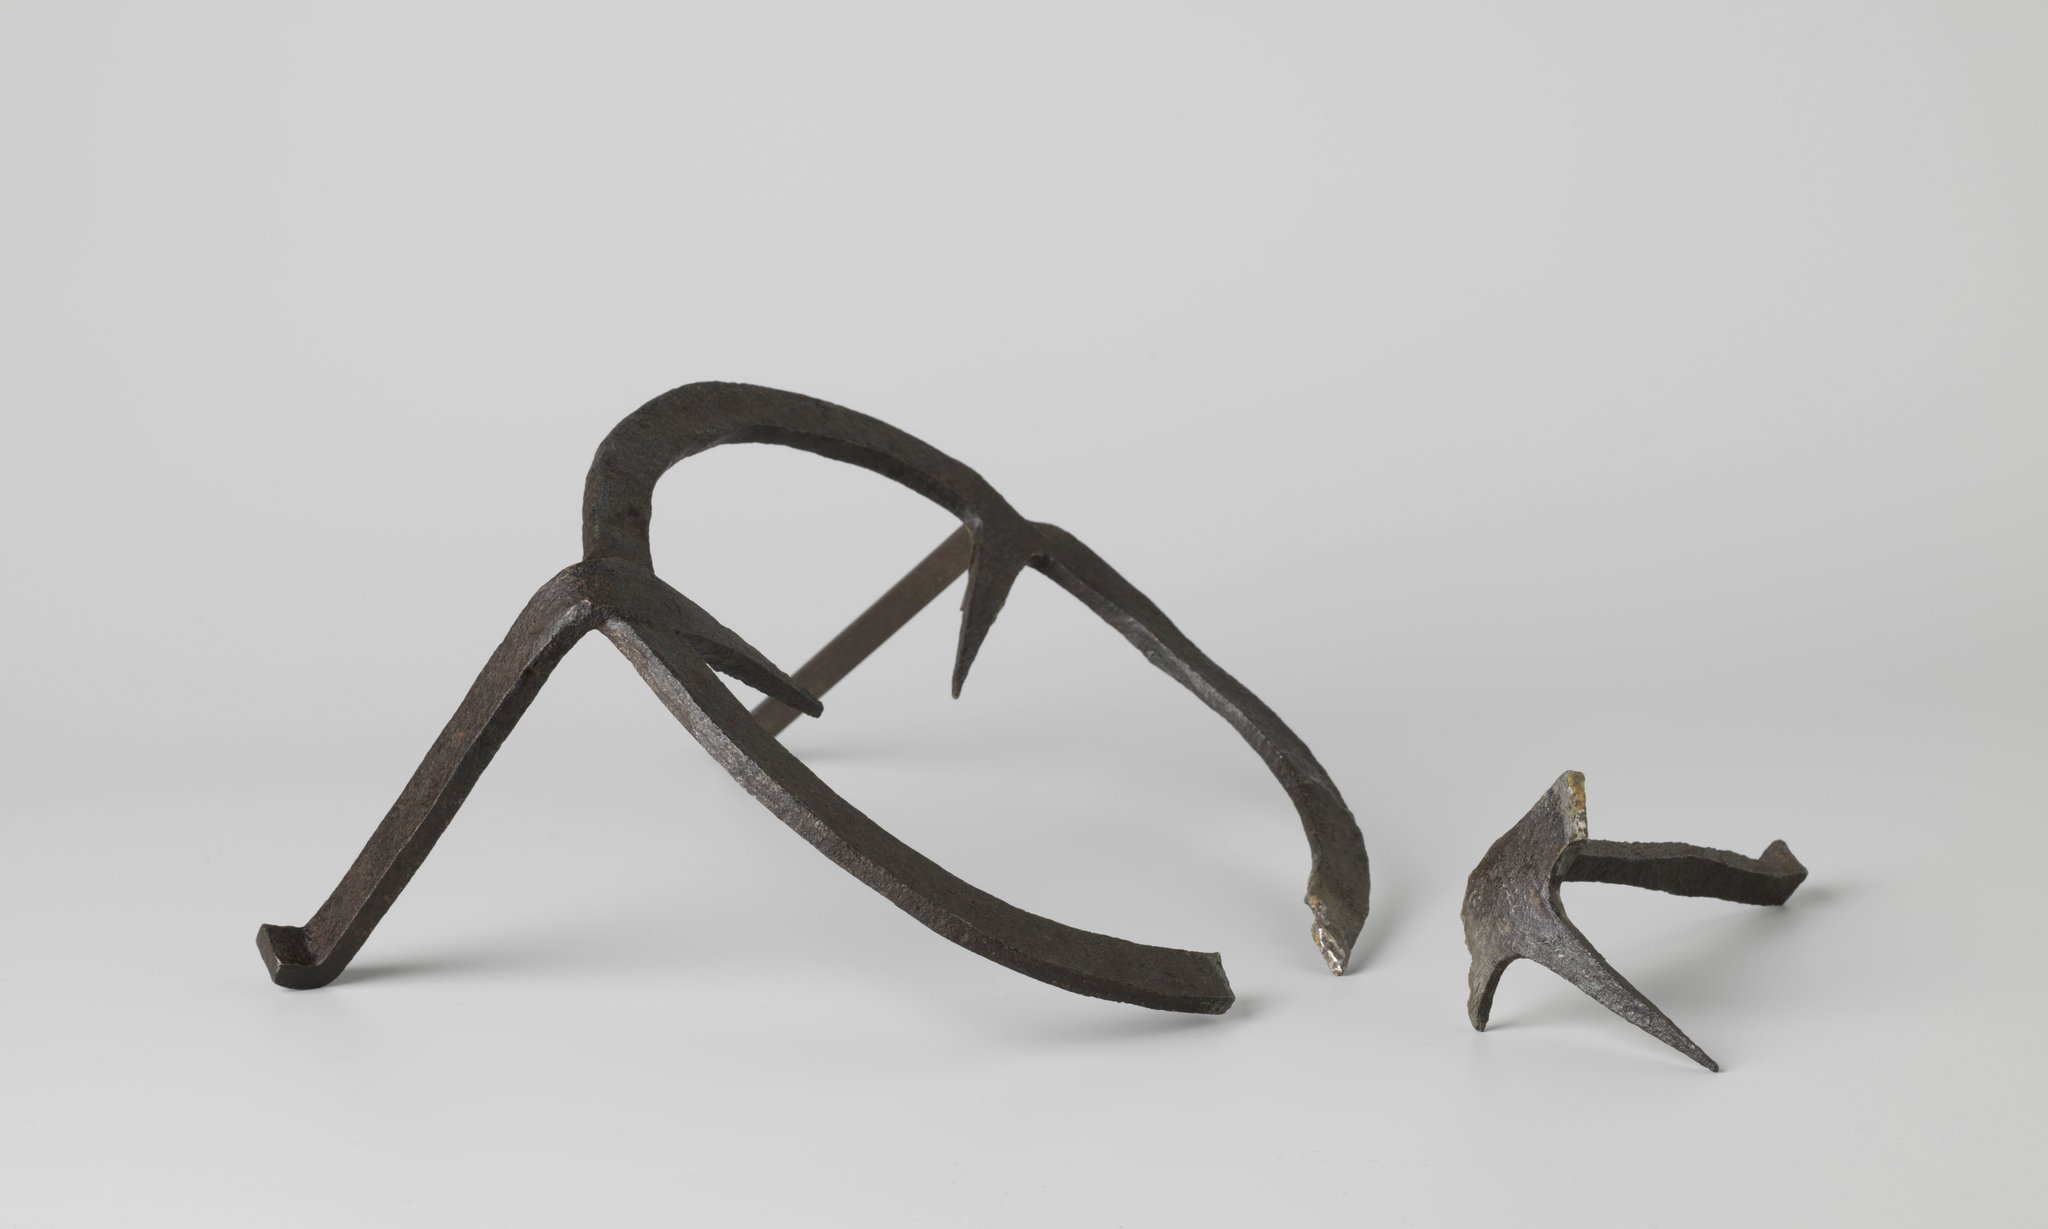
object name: trivet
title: Treeft, ringvormig met drie spitse naar beneden gebogen pootjes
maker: Anonymous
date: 1590-1596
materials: iron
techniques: forging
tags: willem barendsz., amsterdam, jacob van heemskerck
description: Treeft, ringvormig met drie spitse naar beneden gebogen pootjes. Een treeft is een onderzetter voor een pan maar kan ook braadrooster betekenen. Treeft of treft betekent etymologisch drievoet.